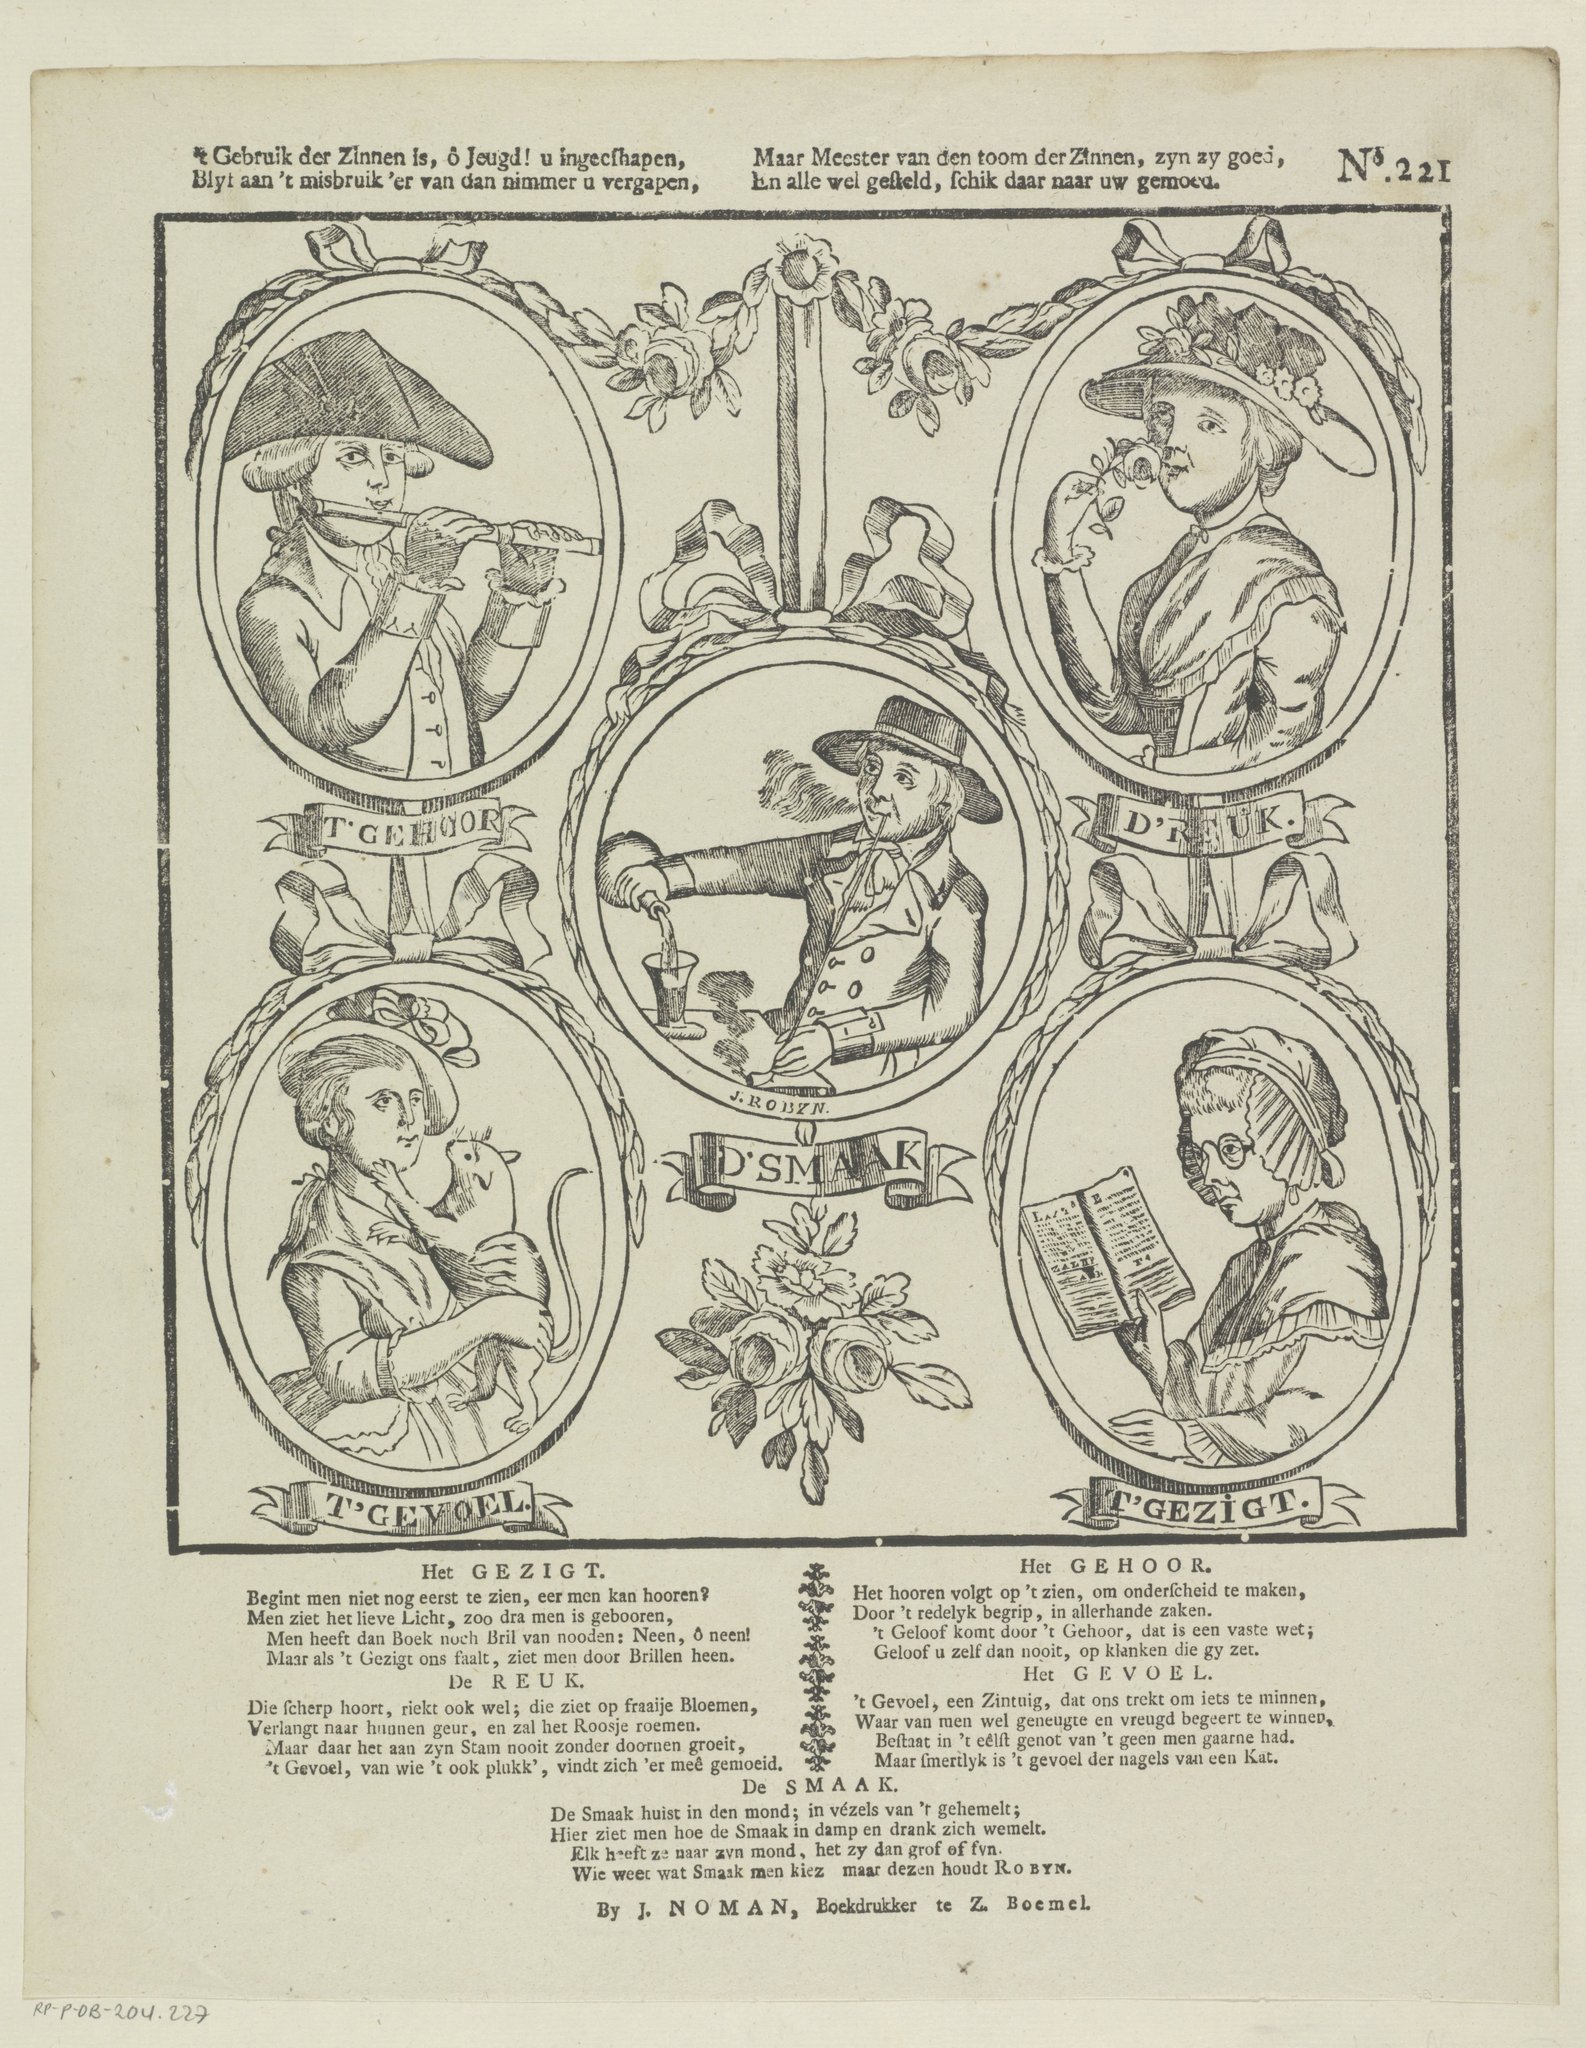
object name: print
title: 't Is Pinkster, en de bloemen praalen / in hoven, velden, groene daalen [(...)]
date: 1806-1830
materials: paper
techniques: letterpress printing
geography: zaltbommel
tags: the (five) senses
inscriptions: collector's mark: Lugt 2760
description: De vijf zintuigen verbeeld door mannen en vrouwen in vijf medaillons, aan elkaar verbonden met linten en bloemenranken. Het geheel is gevat in een kader. Onder de afbeelding vijf korte versjes. Genummerd rechtsboven: No. 221.